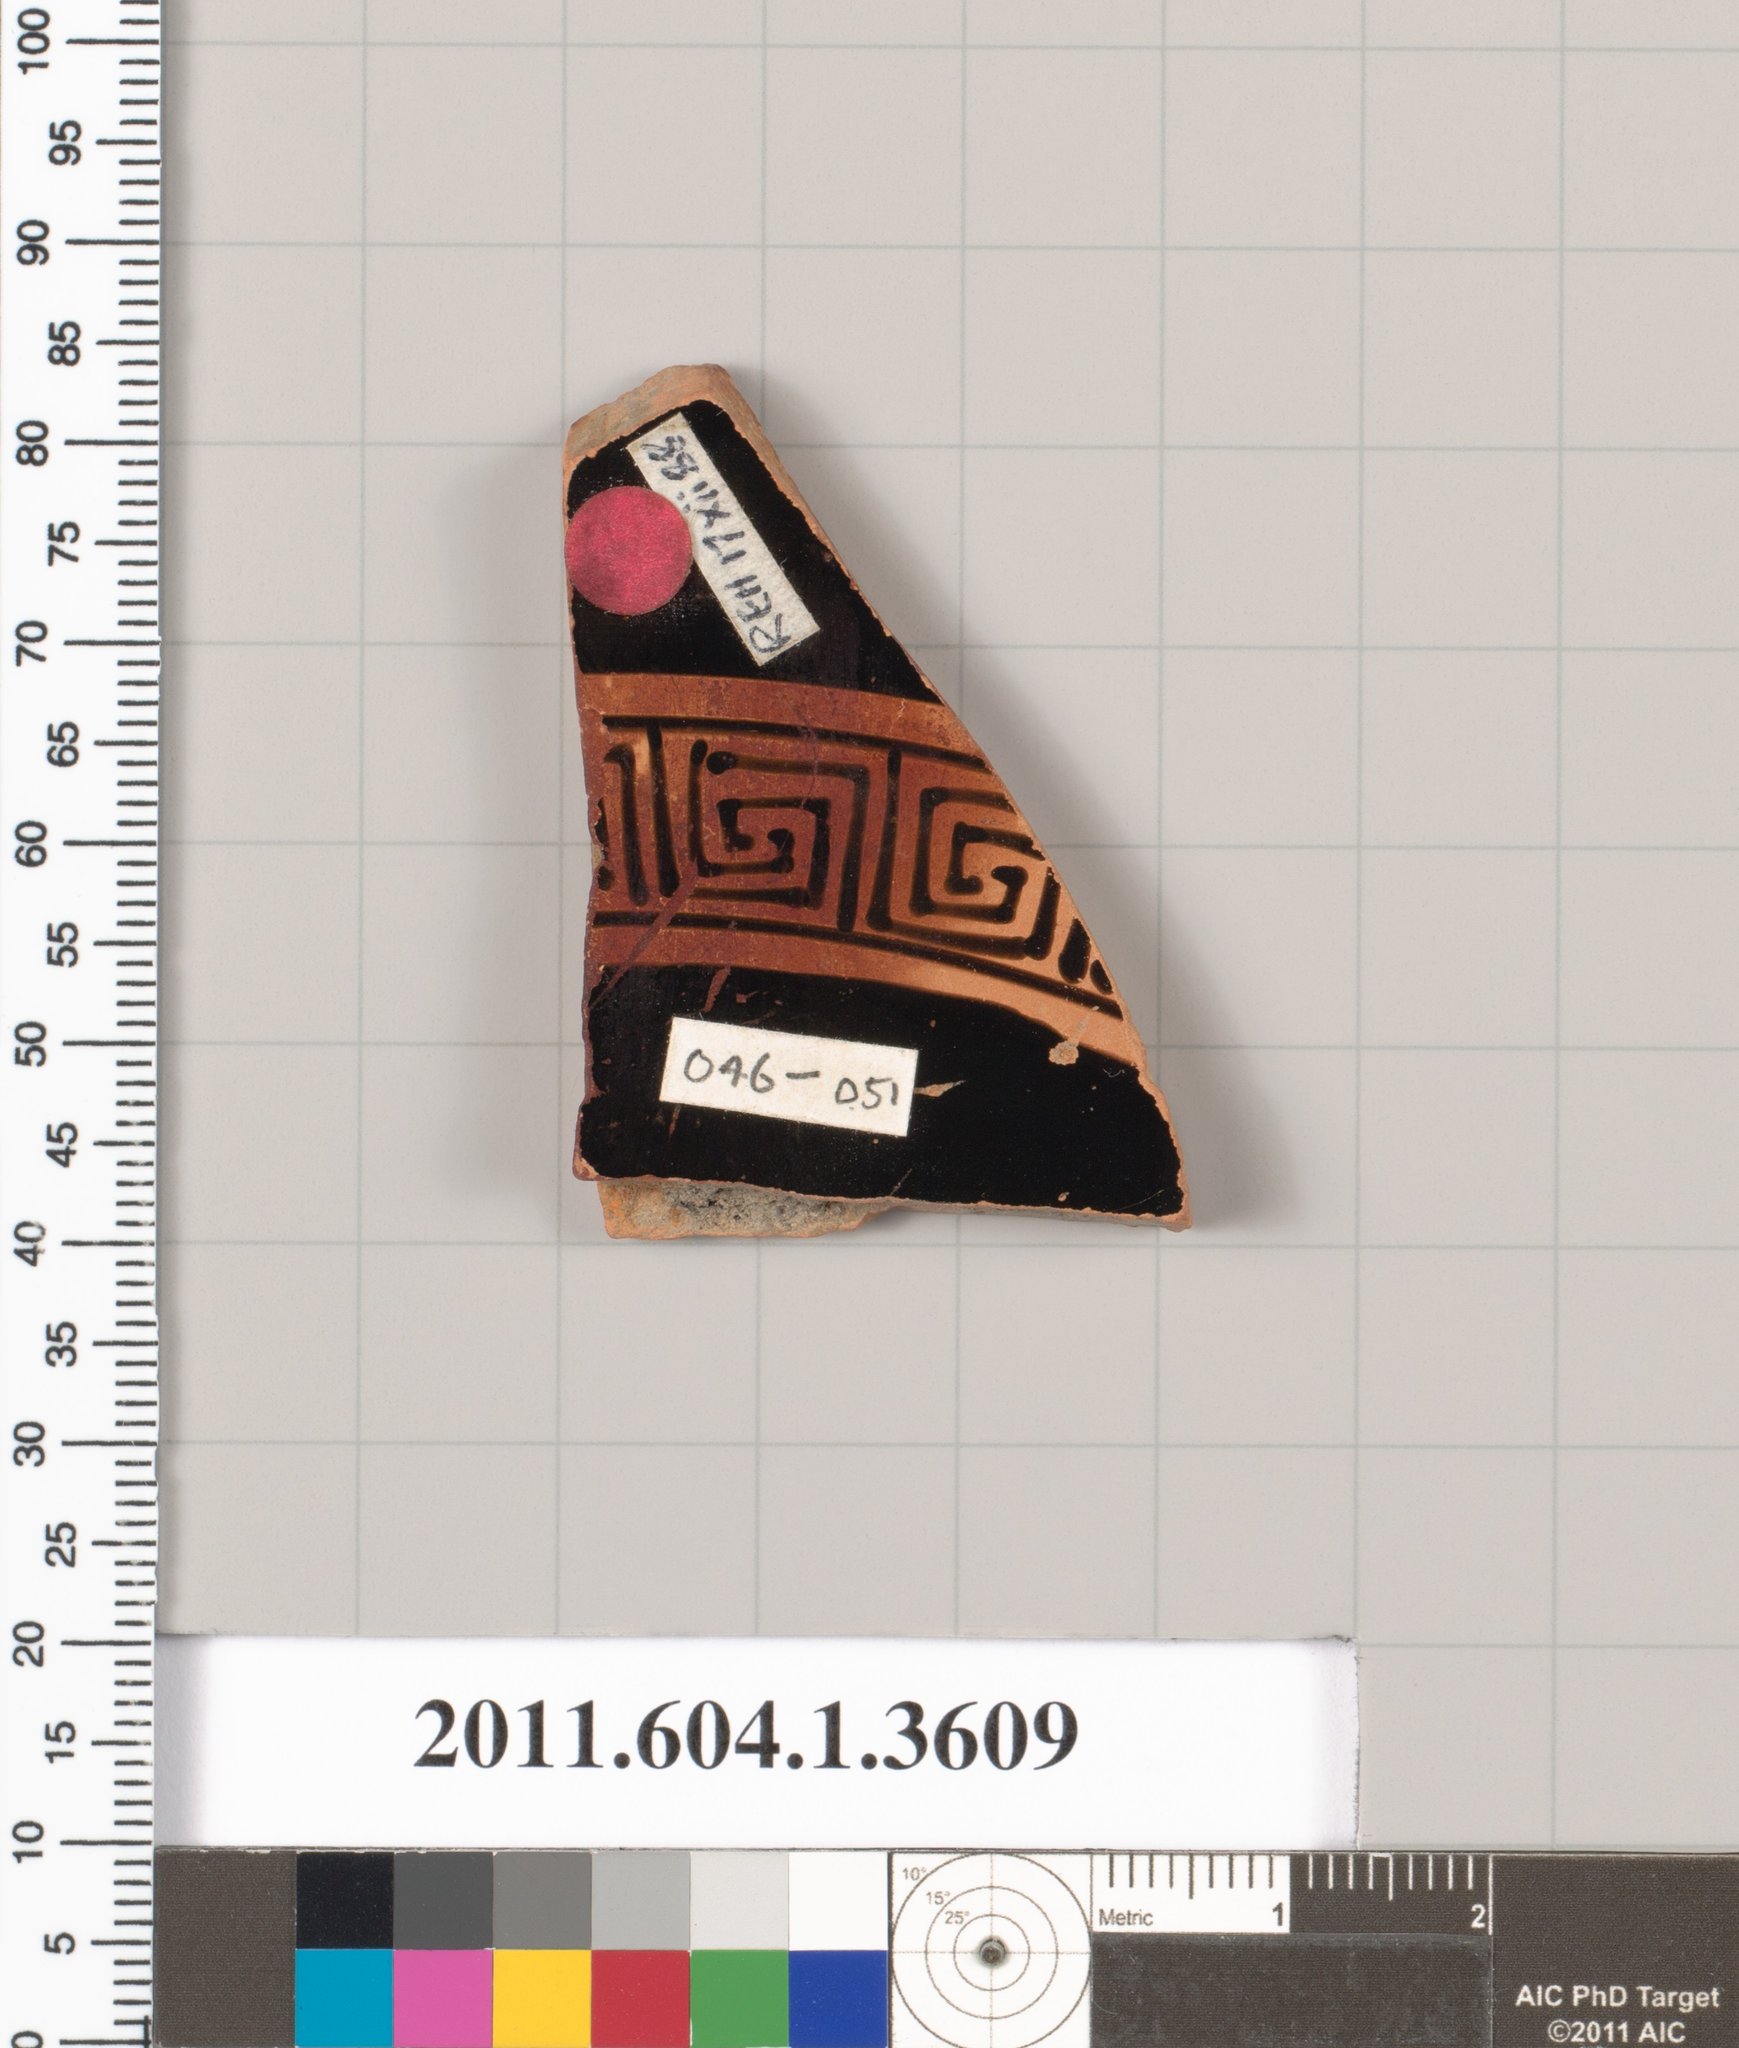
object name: kylix fragment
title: Terracotta fragment of a kylix (drinking cup)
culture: greek, attic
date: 500-470 BCE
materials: terracotta